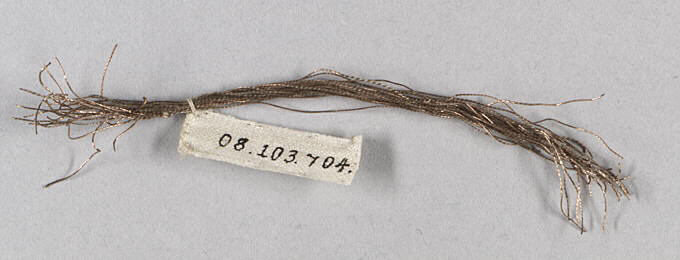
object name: cord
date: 1601-1800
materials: metal thread